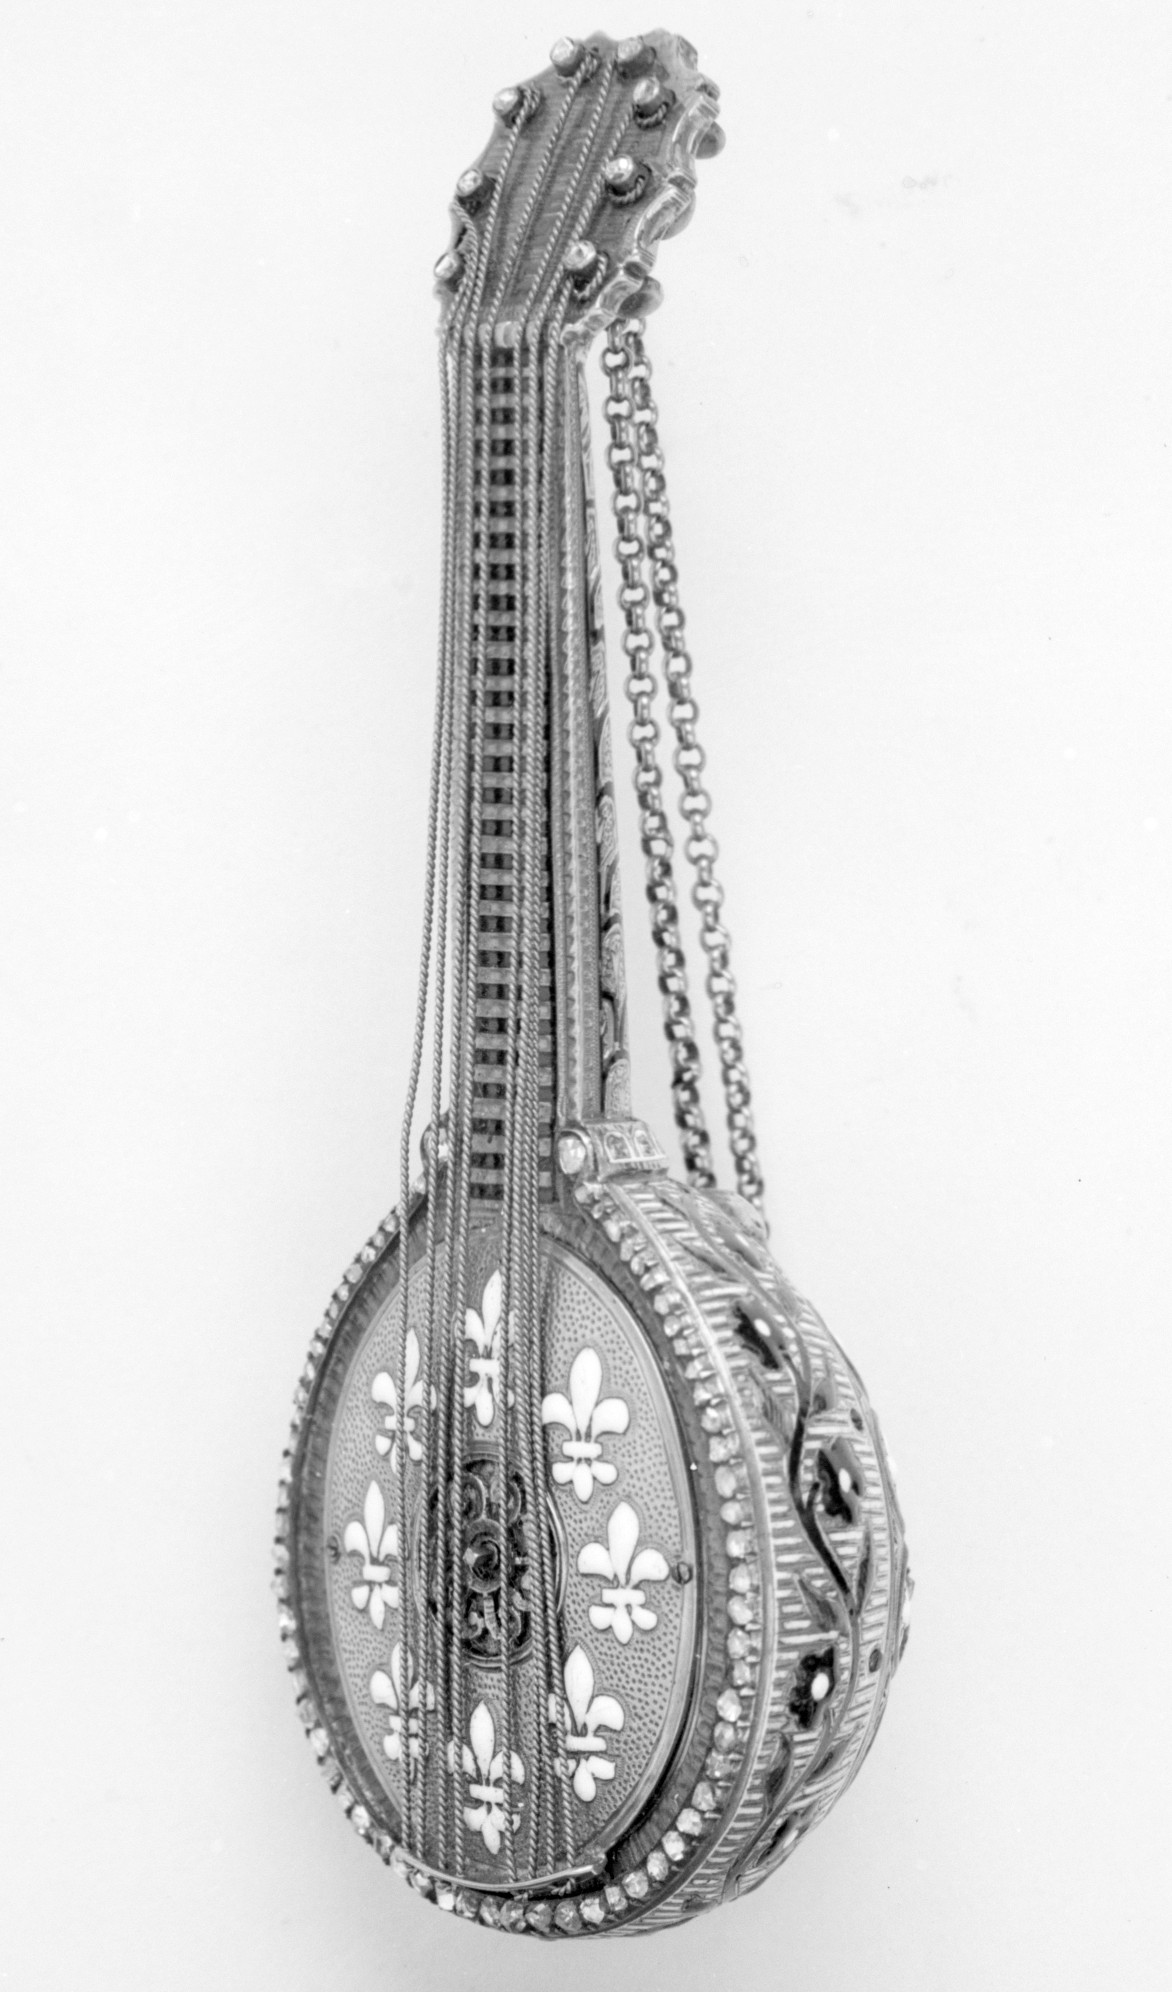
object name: watch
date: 1820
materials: diamond, enamel, gold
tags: lutes